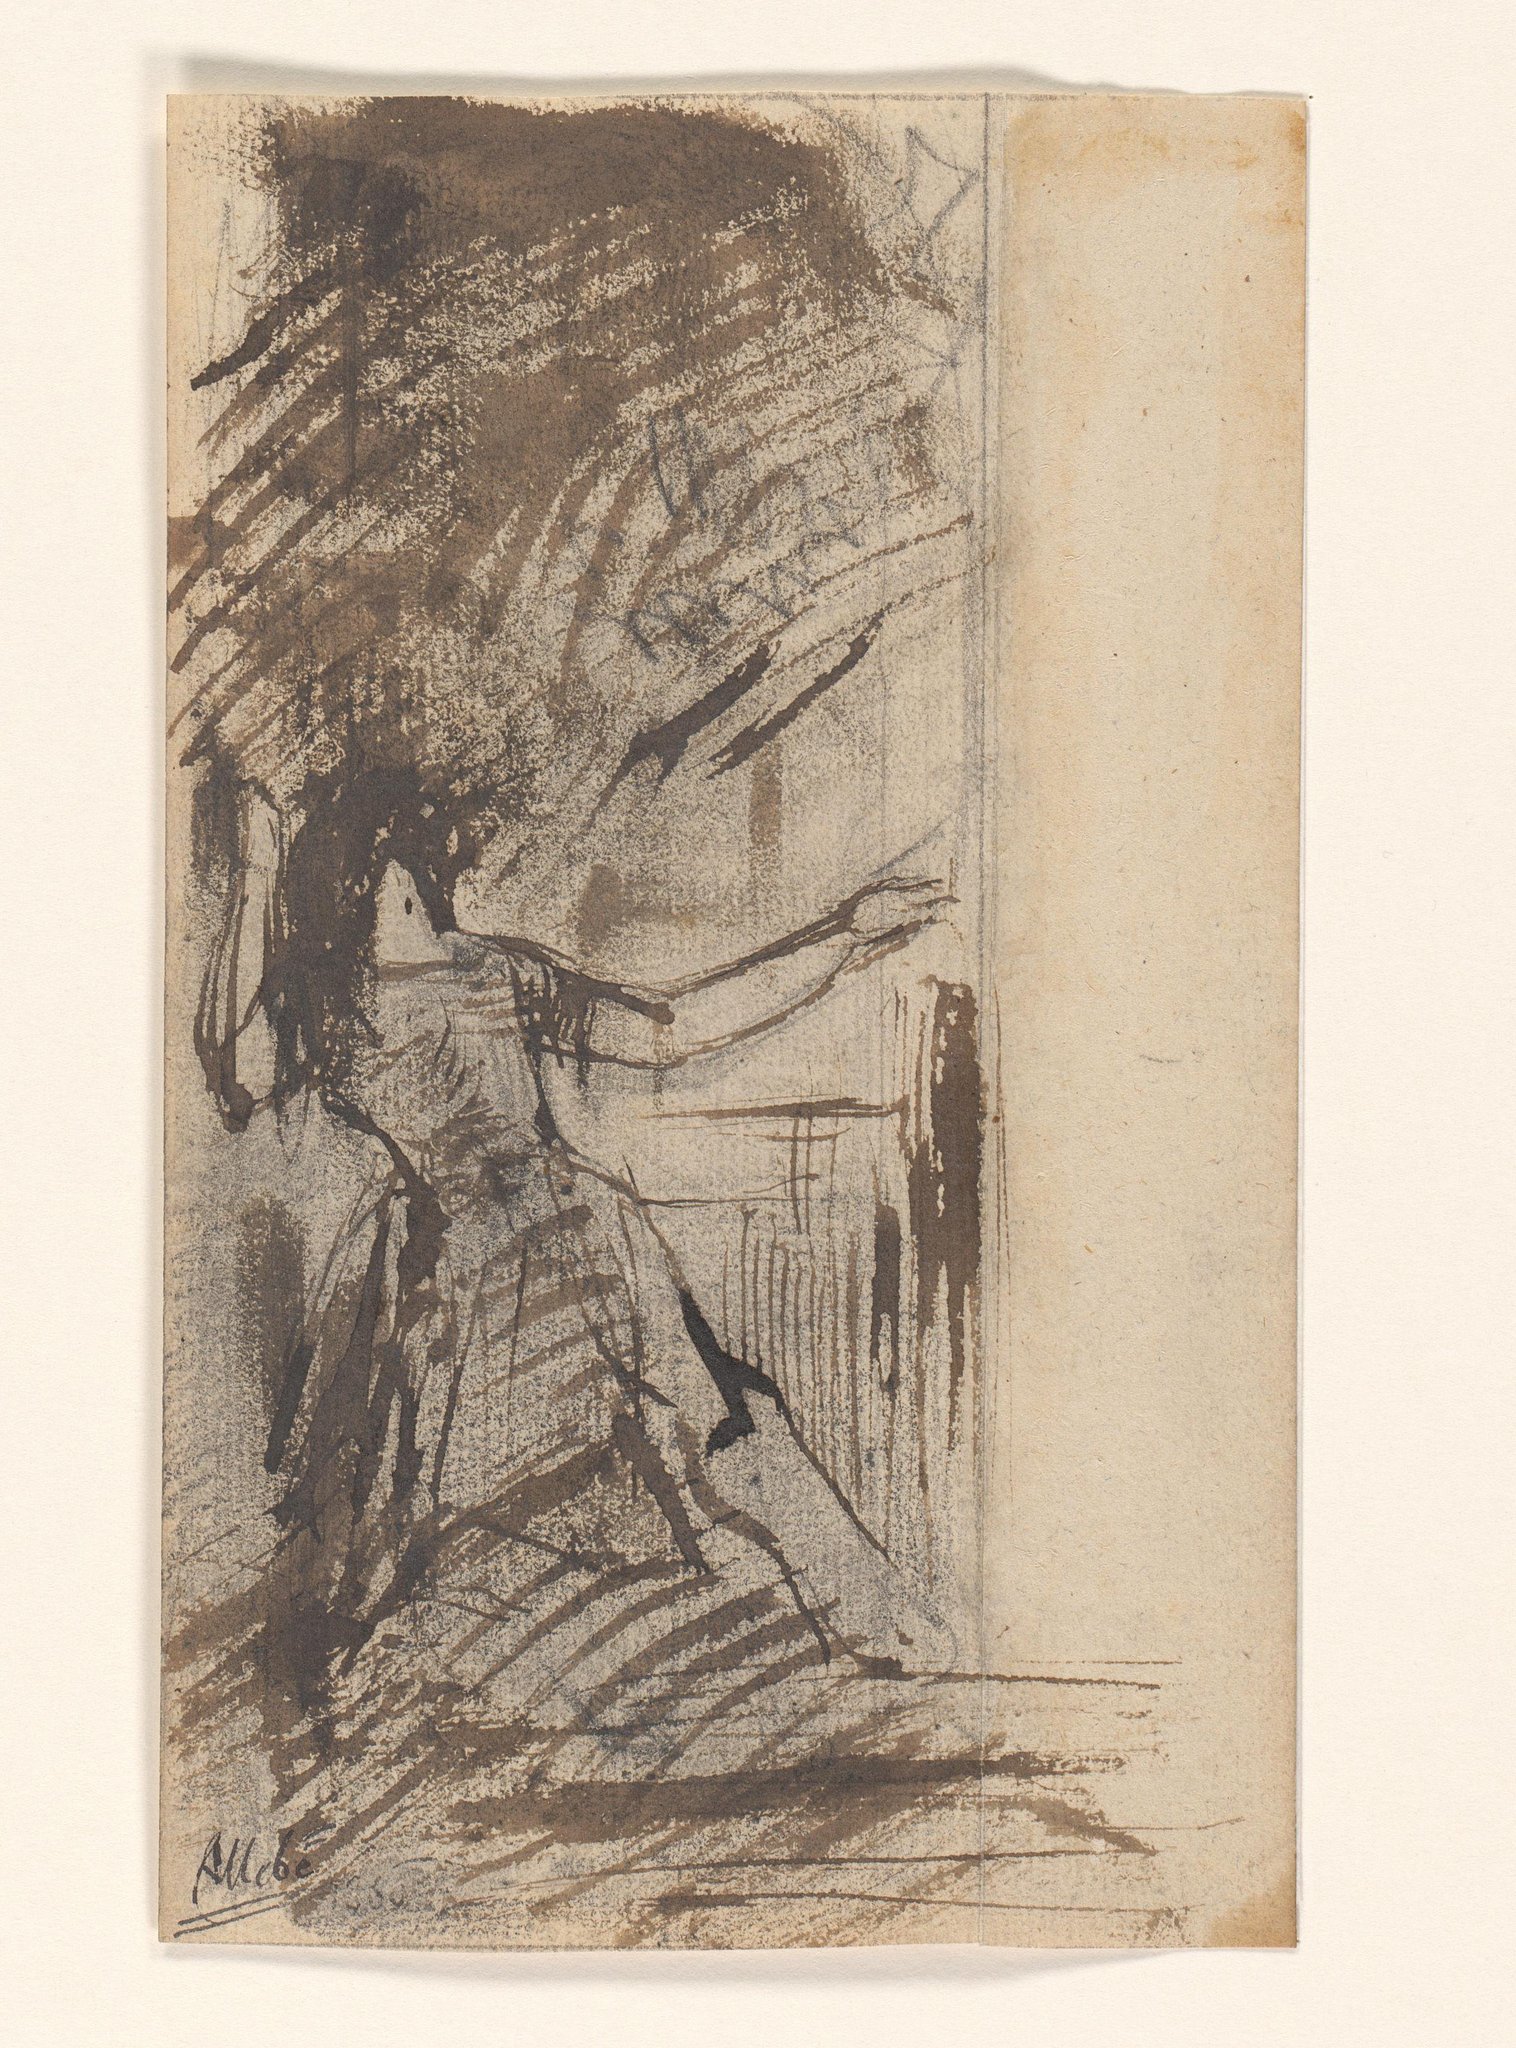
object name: drawing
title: Compositiestudie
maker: august allebé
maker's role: draughtsman, print maker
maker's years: 1838-1927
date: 1860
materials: paper, pencil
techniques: brush